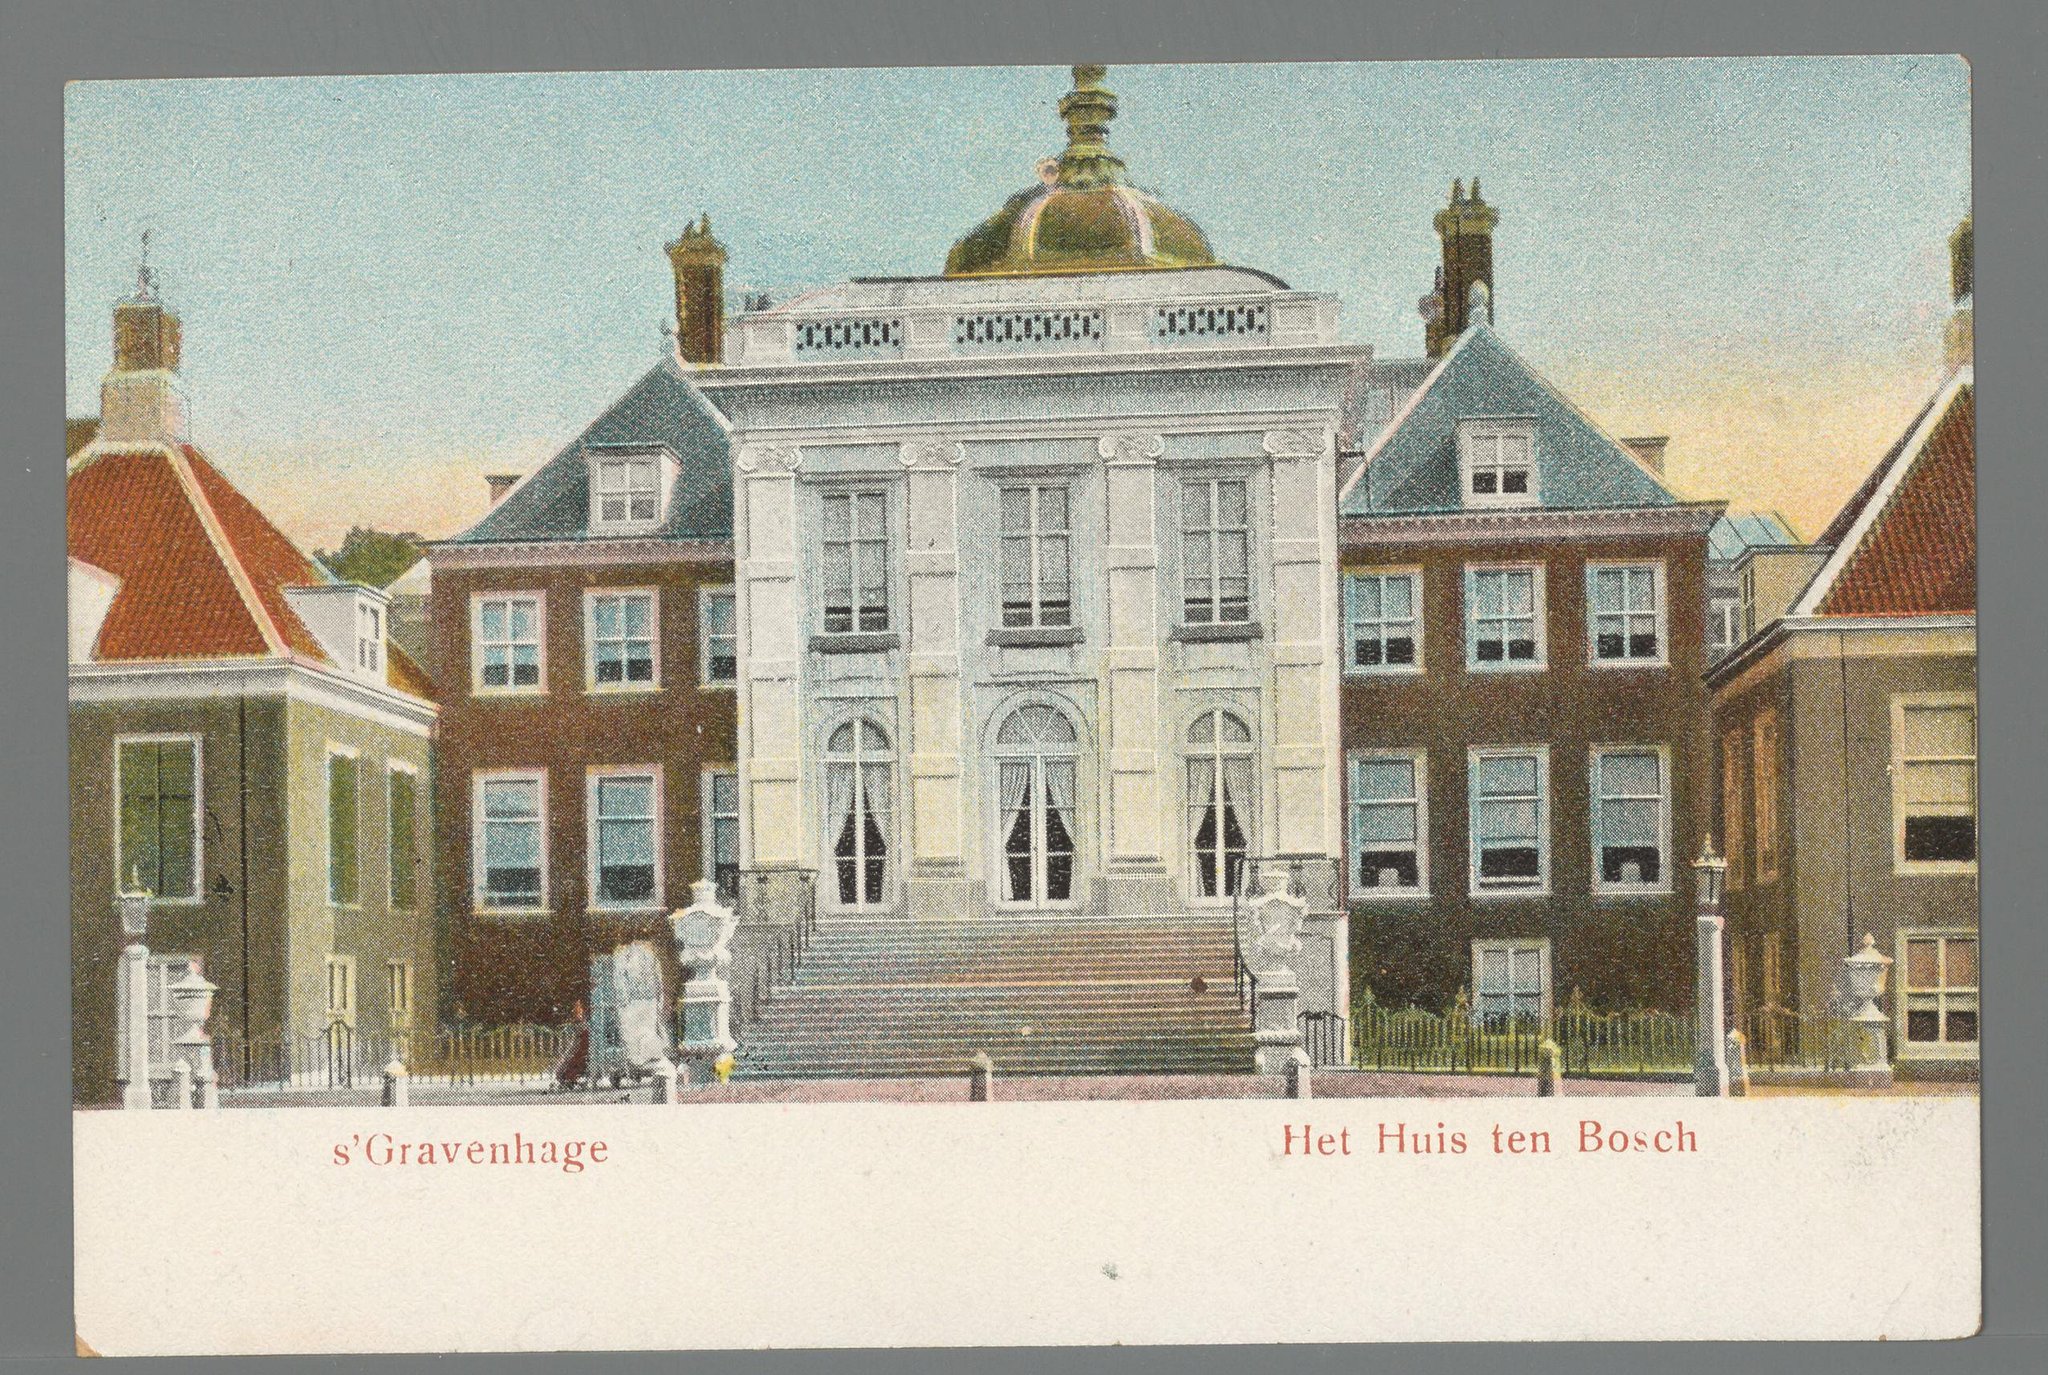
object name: ansichtkaart, prentbriefkaart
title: s'Gravenhage. Het Huis ten Bosch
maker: Anonymous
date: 1897-1905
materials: cardboard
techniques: lithograph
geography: the hague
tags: palace